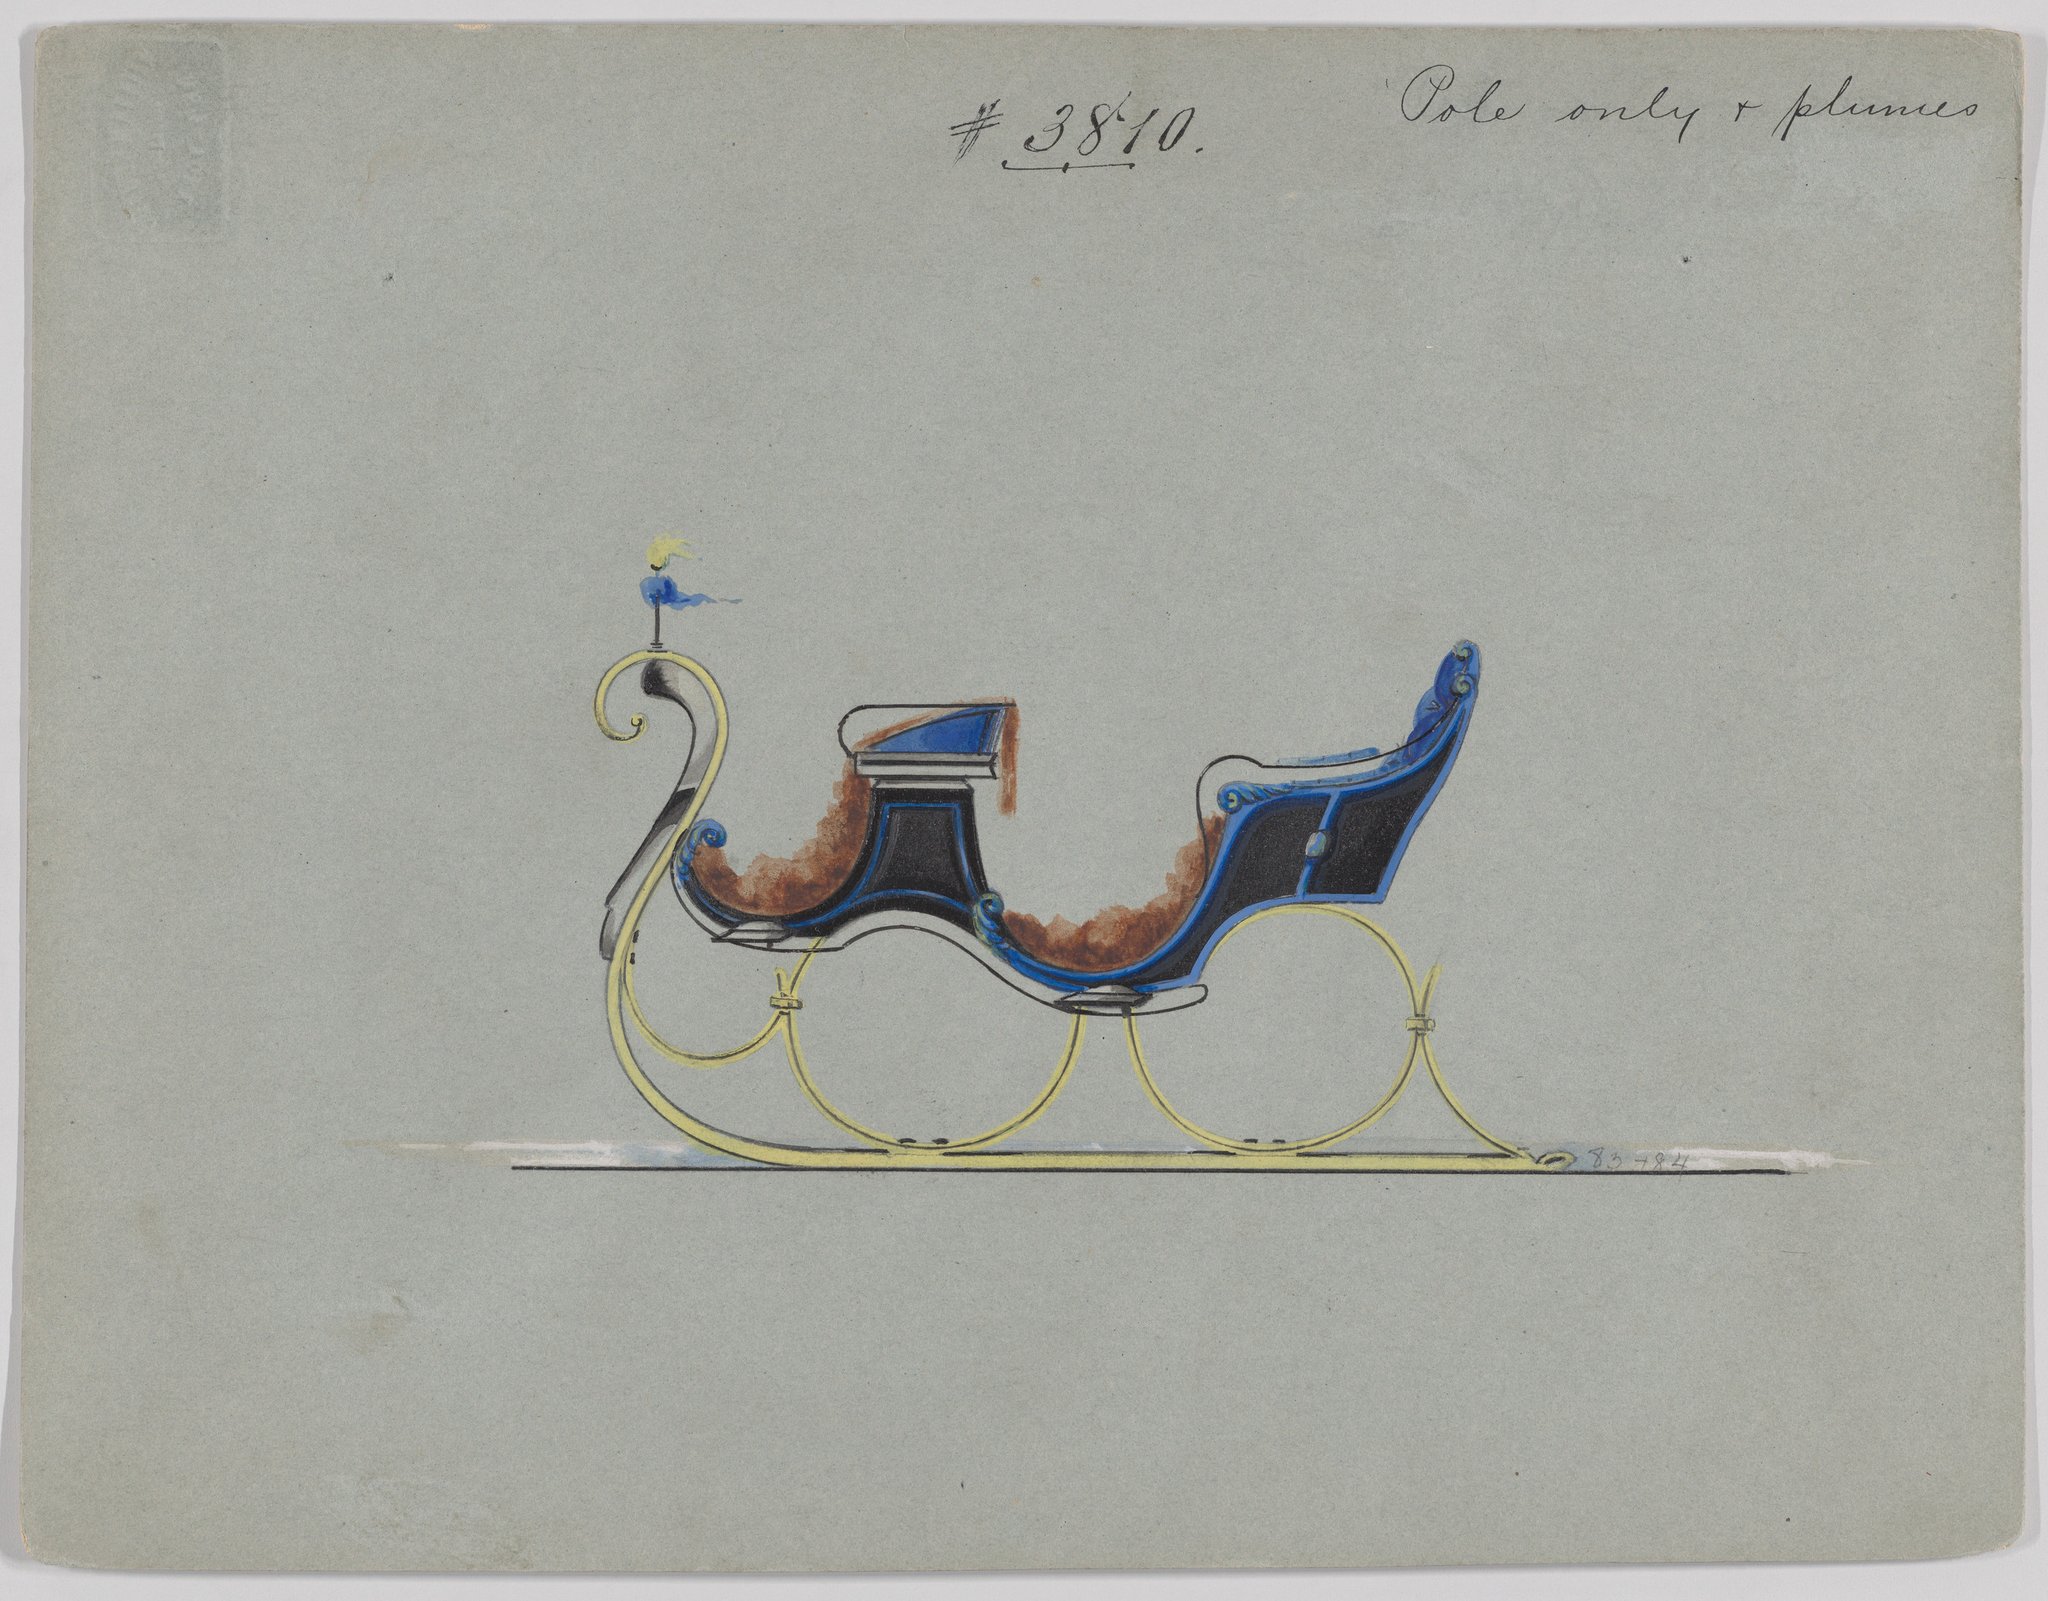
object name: drawing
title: Design for 4 Seat Sleigh, no. 3810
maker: brewster & co.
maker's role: manufacturer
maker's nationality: american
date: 1883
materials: gouache, gum arabic, ink, watercolor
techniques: pen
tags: sleighs